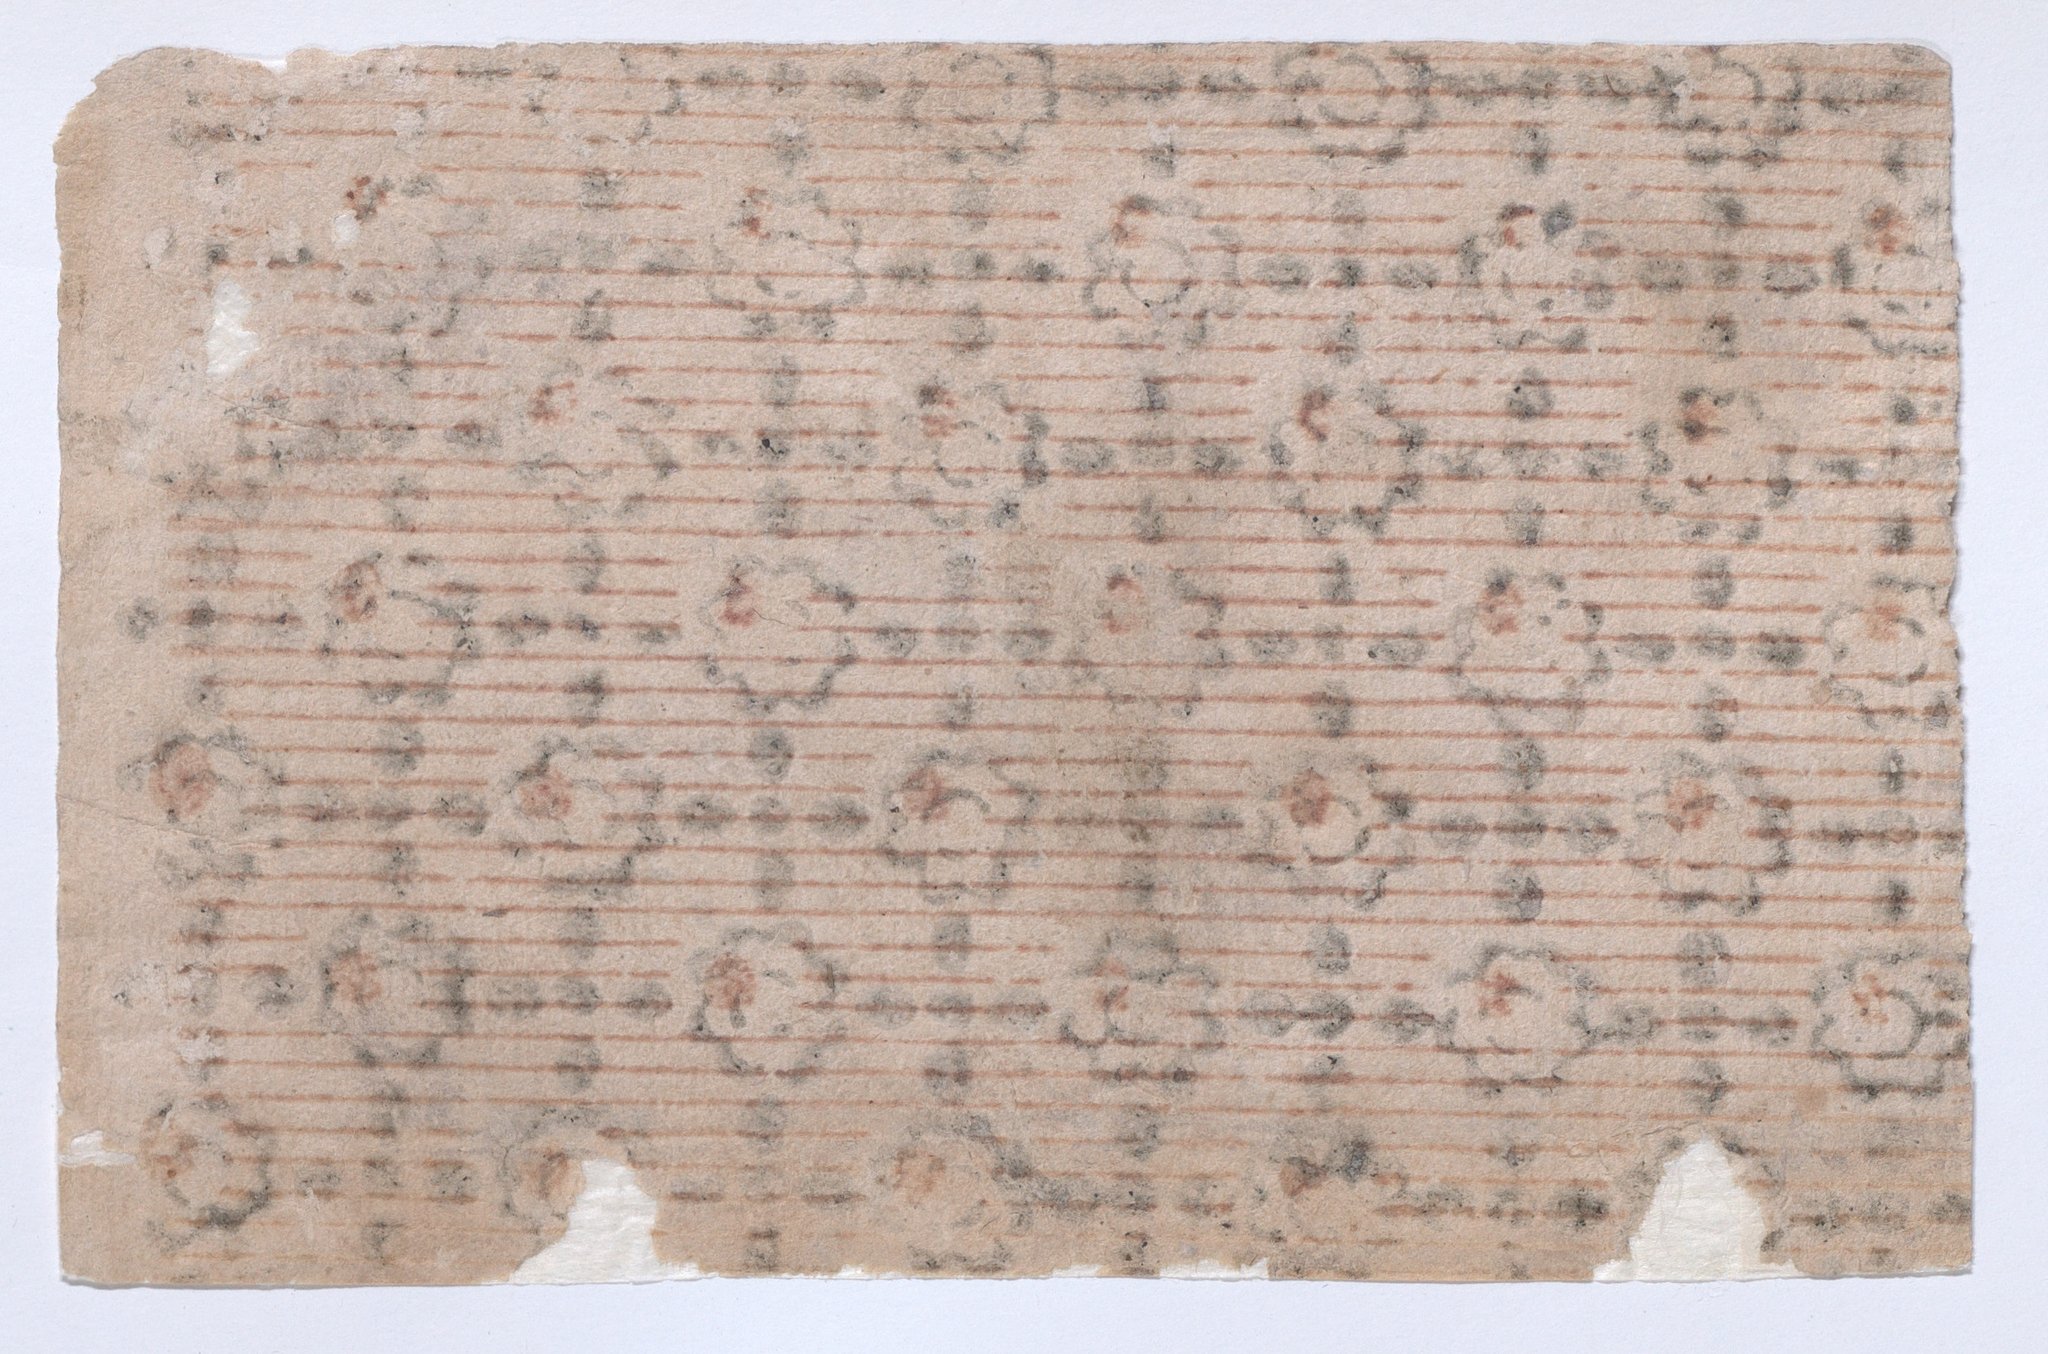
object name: print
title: Sheet with stripe and floral pattern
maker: Anonymous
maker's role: artist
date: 1801-1900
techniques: relief print